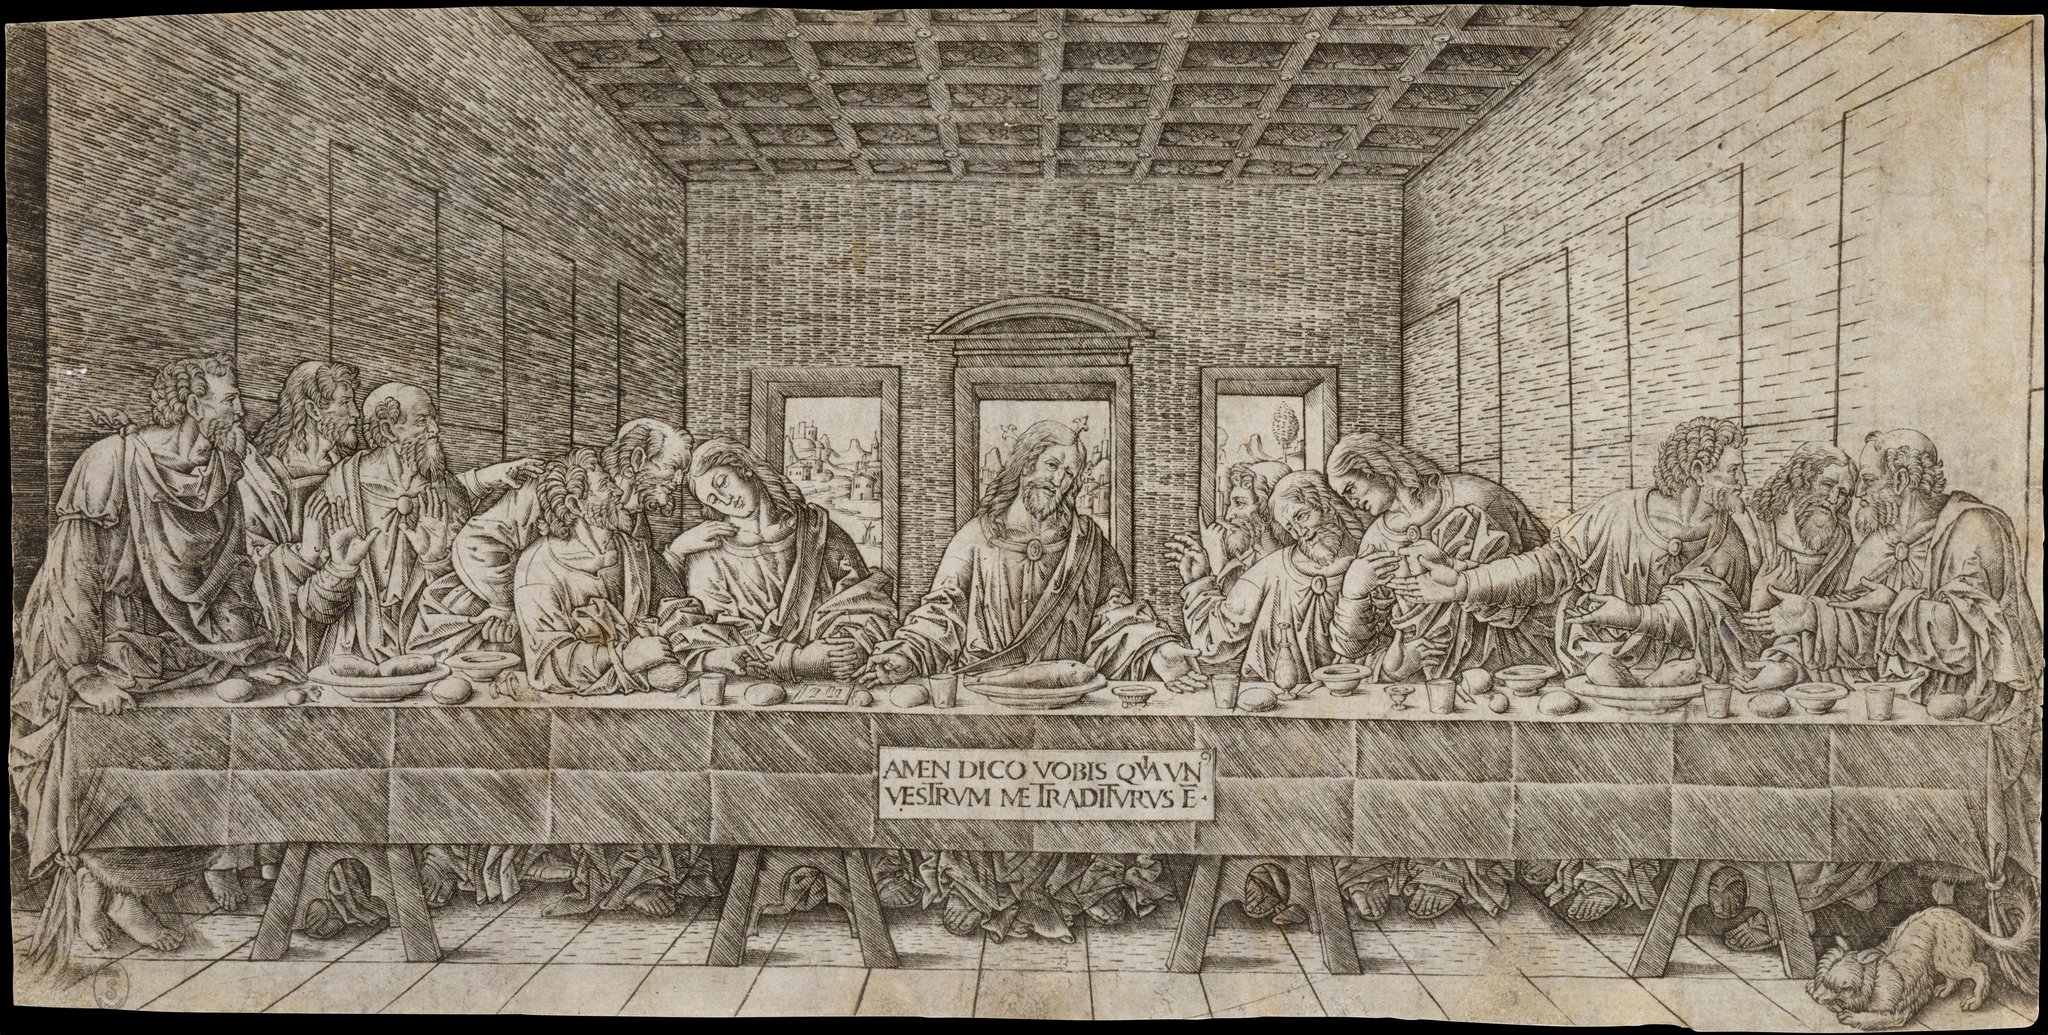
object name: print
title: The Last Supper, with a Spaniel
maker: giovanni pietro da birago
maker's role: artist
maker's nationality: italian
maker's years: 1470-1513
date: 1500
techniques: engraving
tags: dogs,christ,last supper,tables